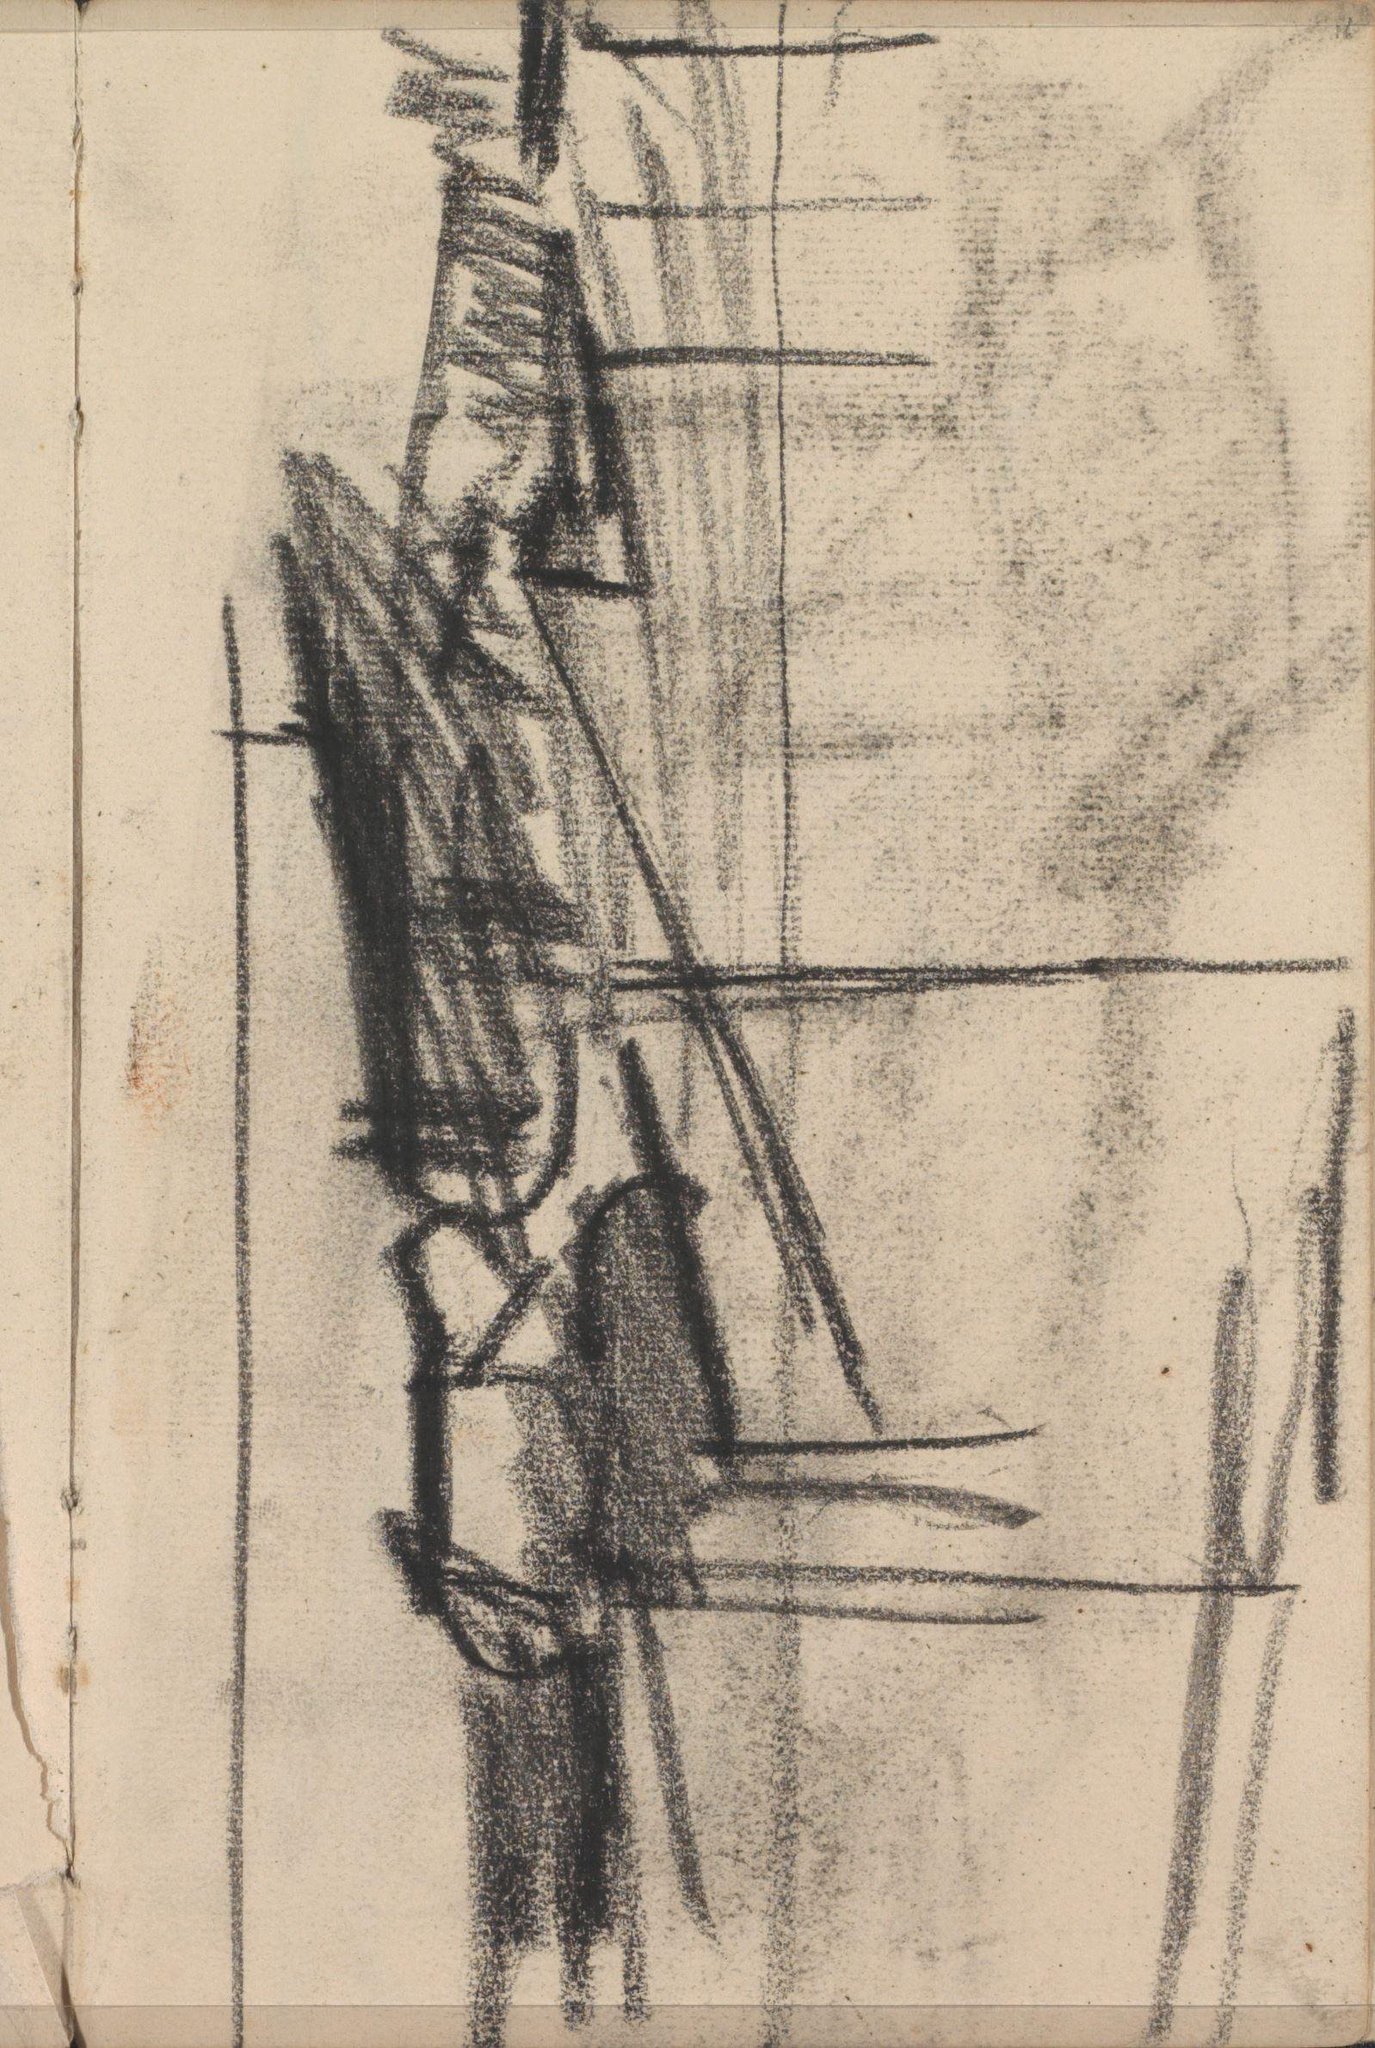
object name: sketchbook leaf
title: Aangemeerde schepen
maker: george hendrik breitner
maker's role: draughtsman, painter, print maker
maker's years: 1857-1923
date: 1886-1923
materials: chalk, paper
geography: amsterdam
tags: ships (in general)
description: Pagina 16 uit een schetsboek met 17 bladen.